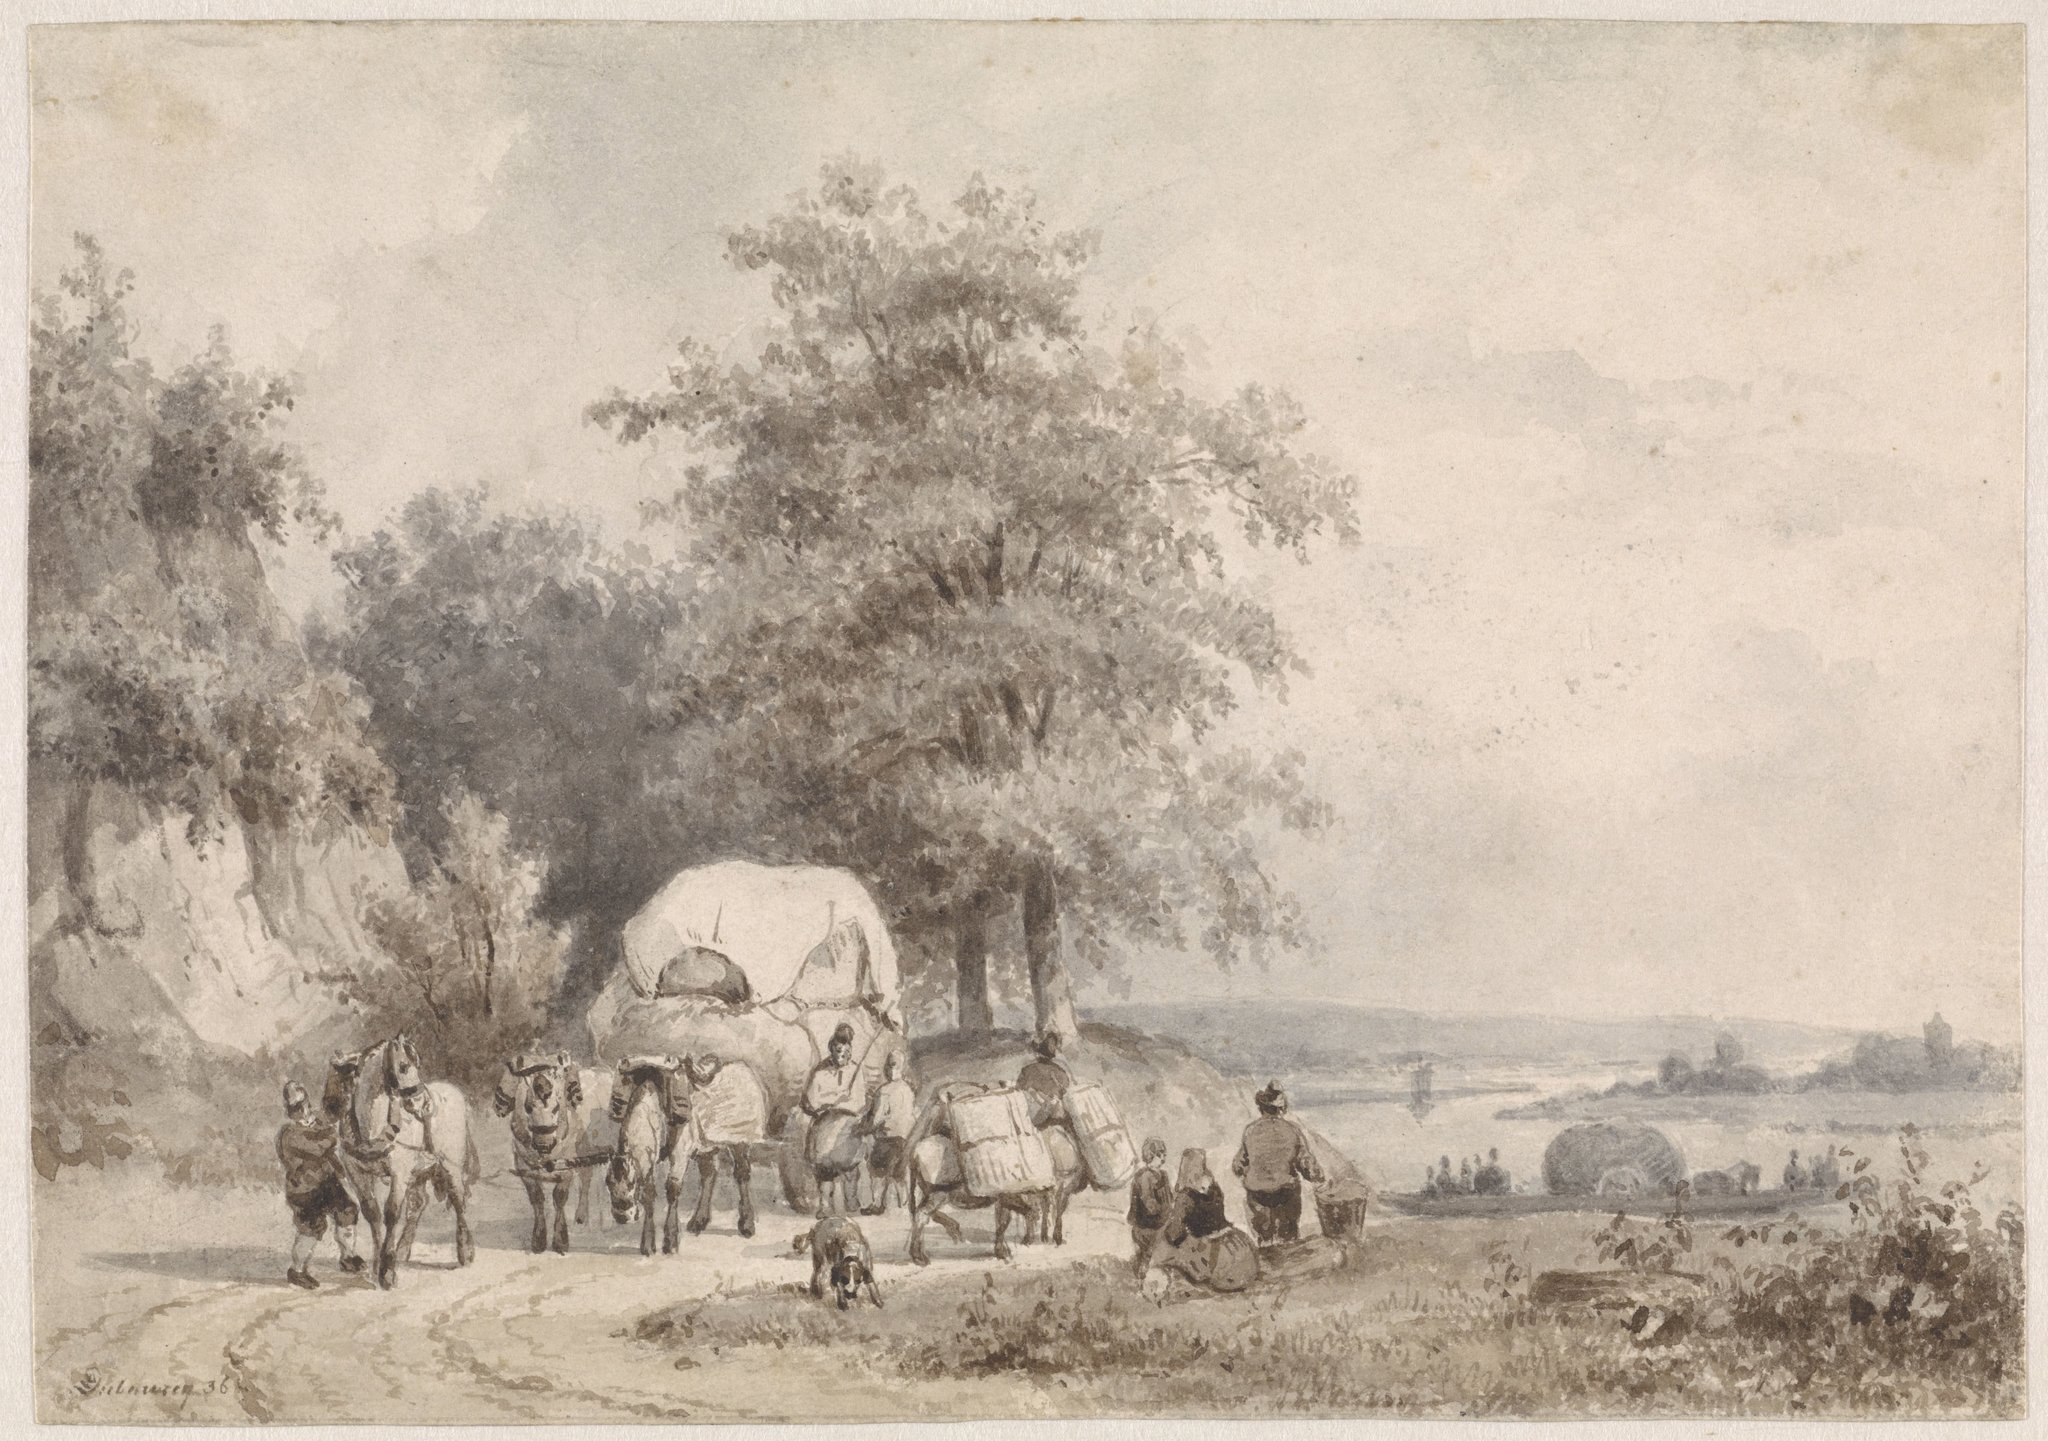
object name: drawing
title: Landschap met hooiwagen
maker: pierre louis dubourcq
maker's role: draughtsman, painter, print maker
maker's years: 1815-1873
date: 1836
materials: paper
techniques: brush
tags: hay-wagon